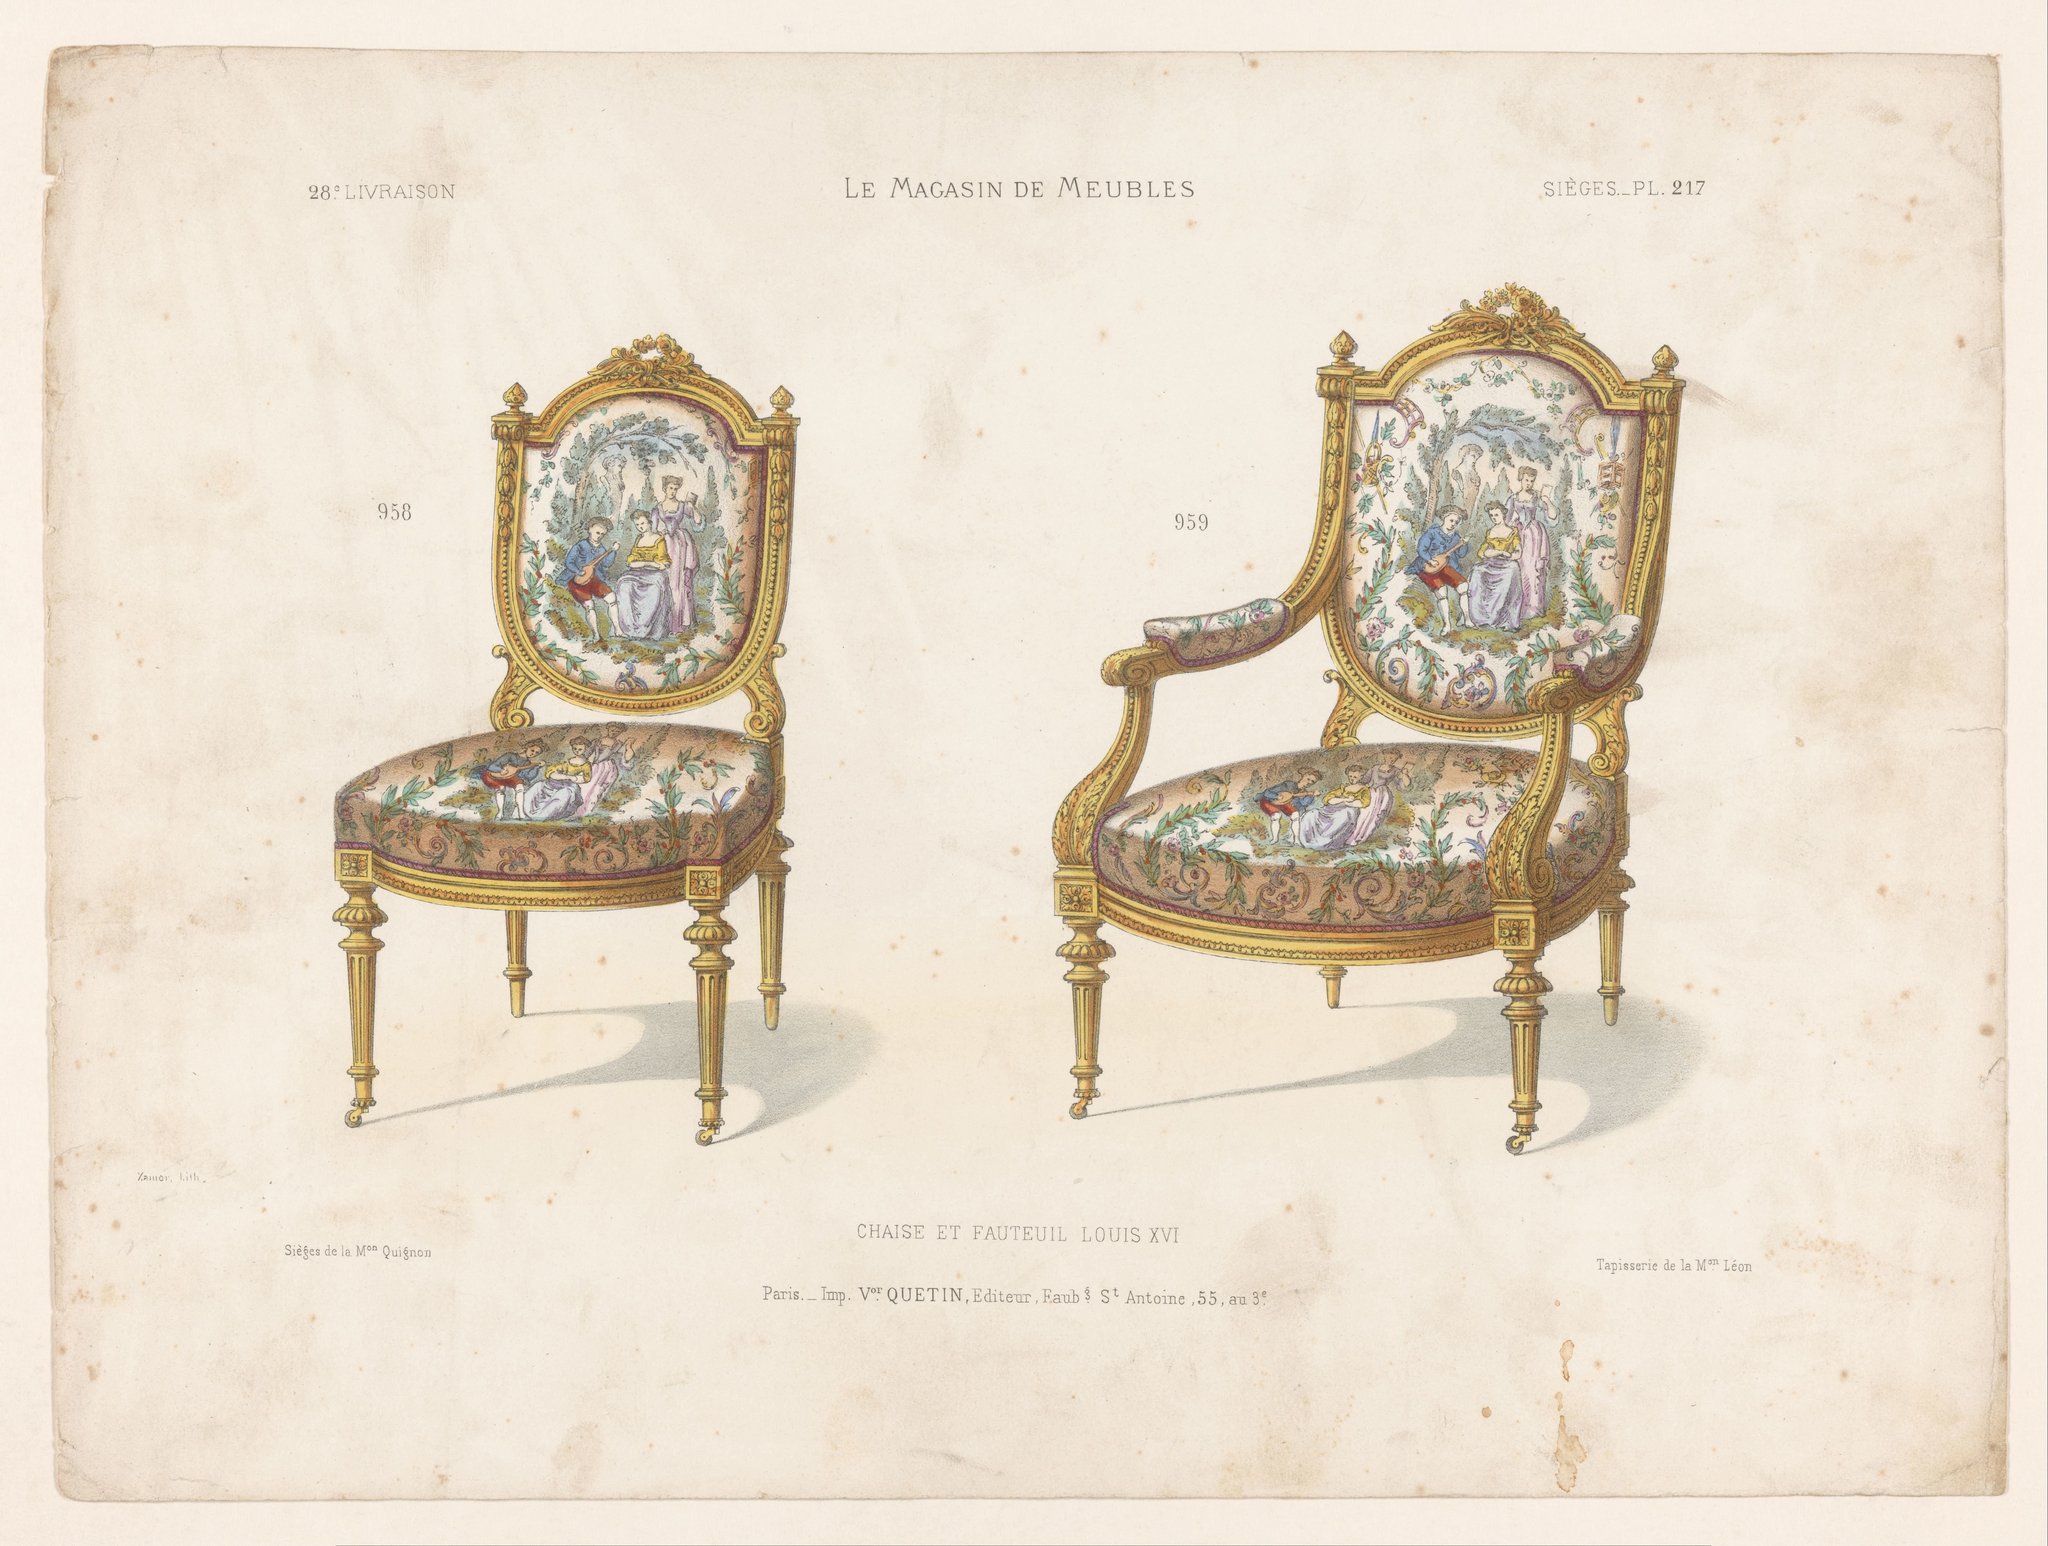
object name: print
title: Chaise et fauteuil Louis XVI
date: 1832-1877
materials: paper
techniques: hand coloring, lithograph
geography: paris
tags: seating furniture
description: Een stoel en fauteuil in de Lodewijk XVI-stijl. Prent uit 28e Livraison.